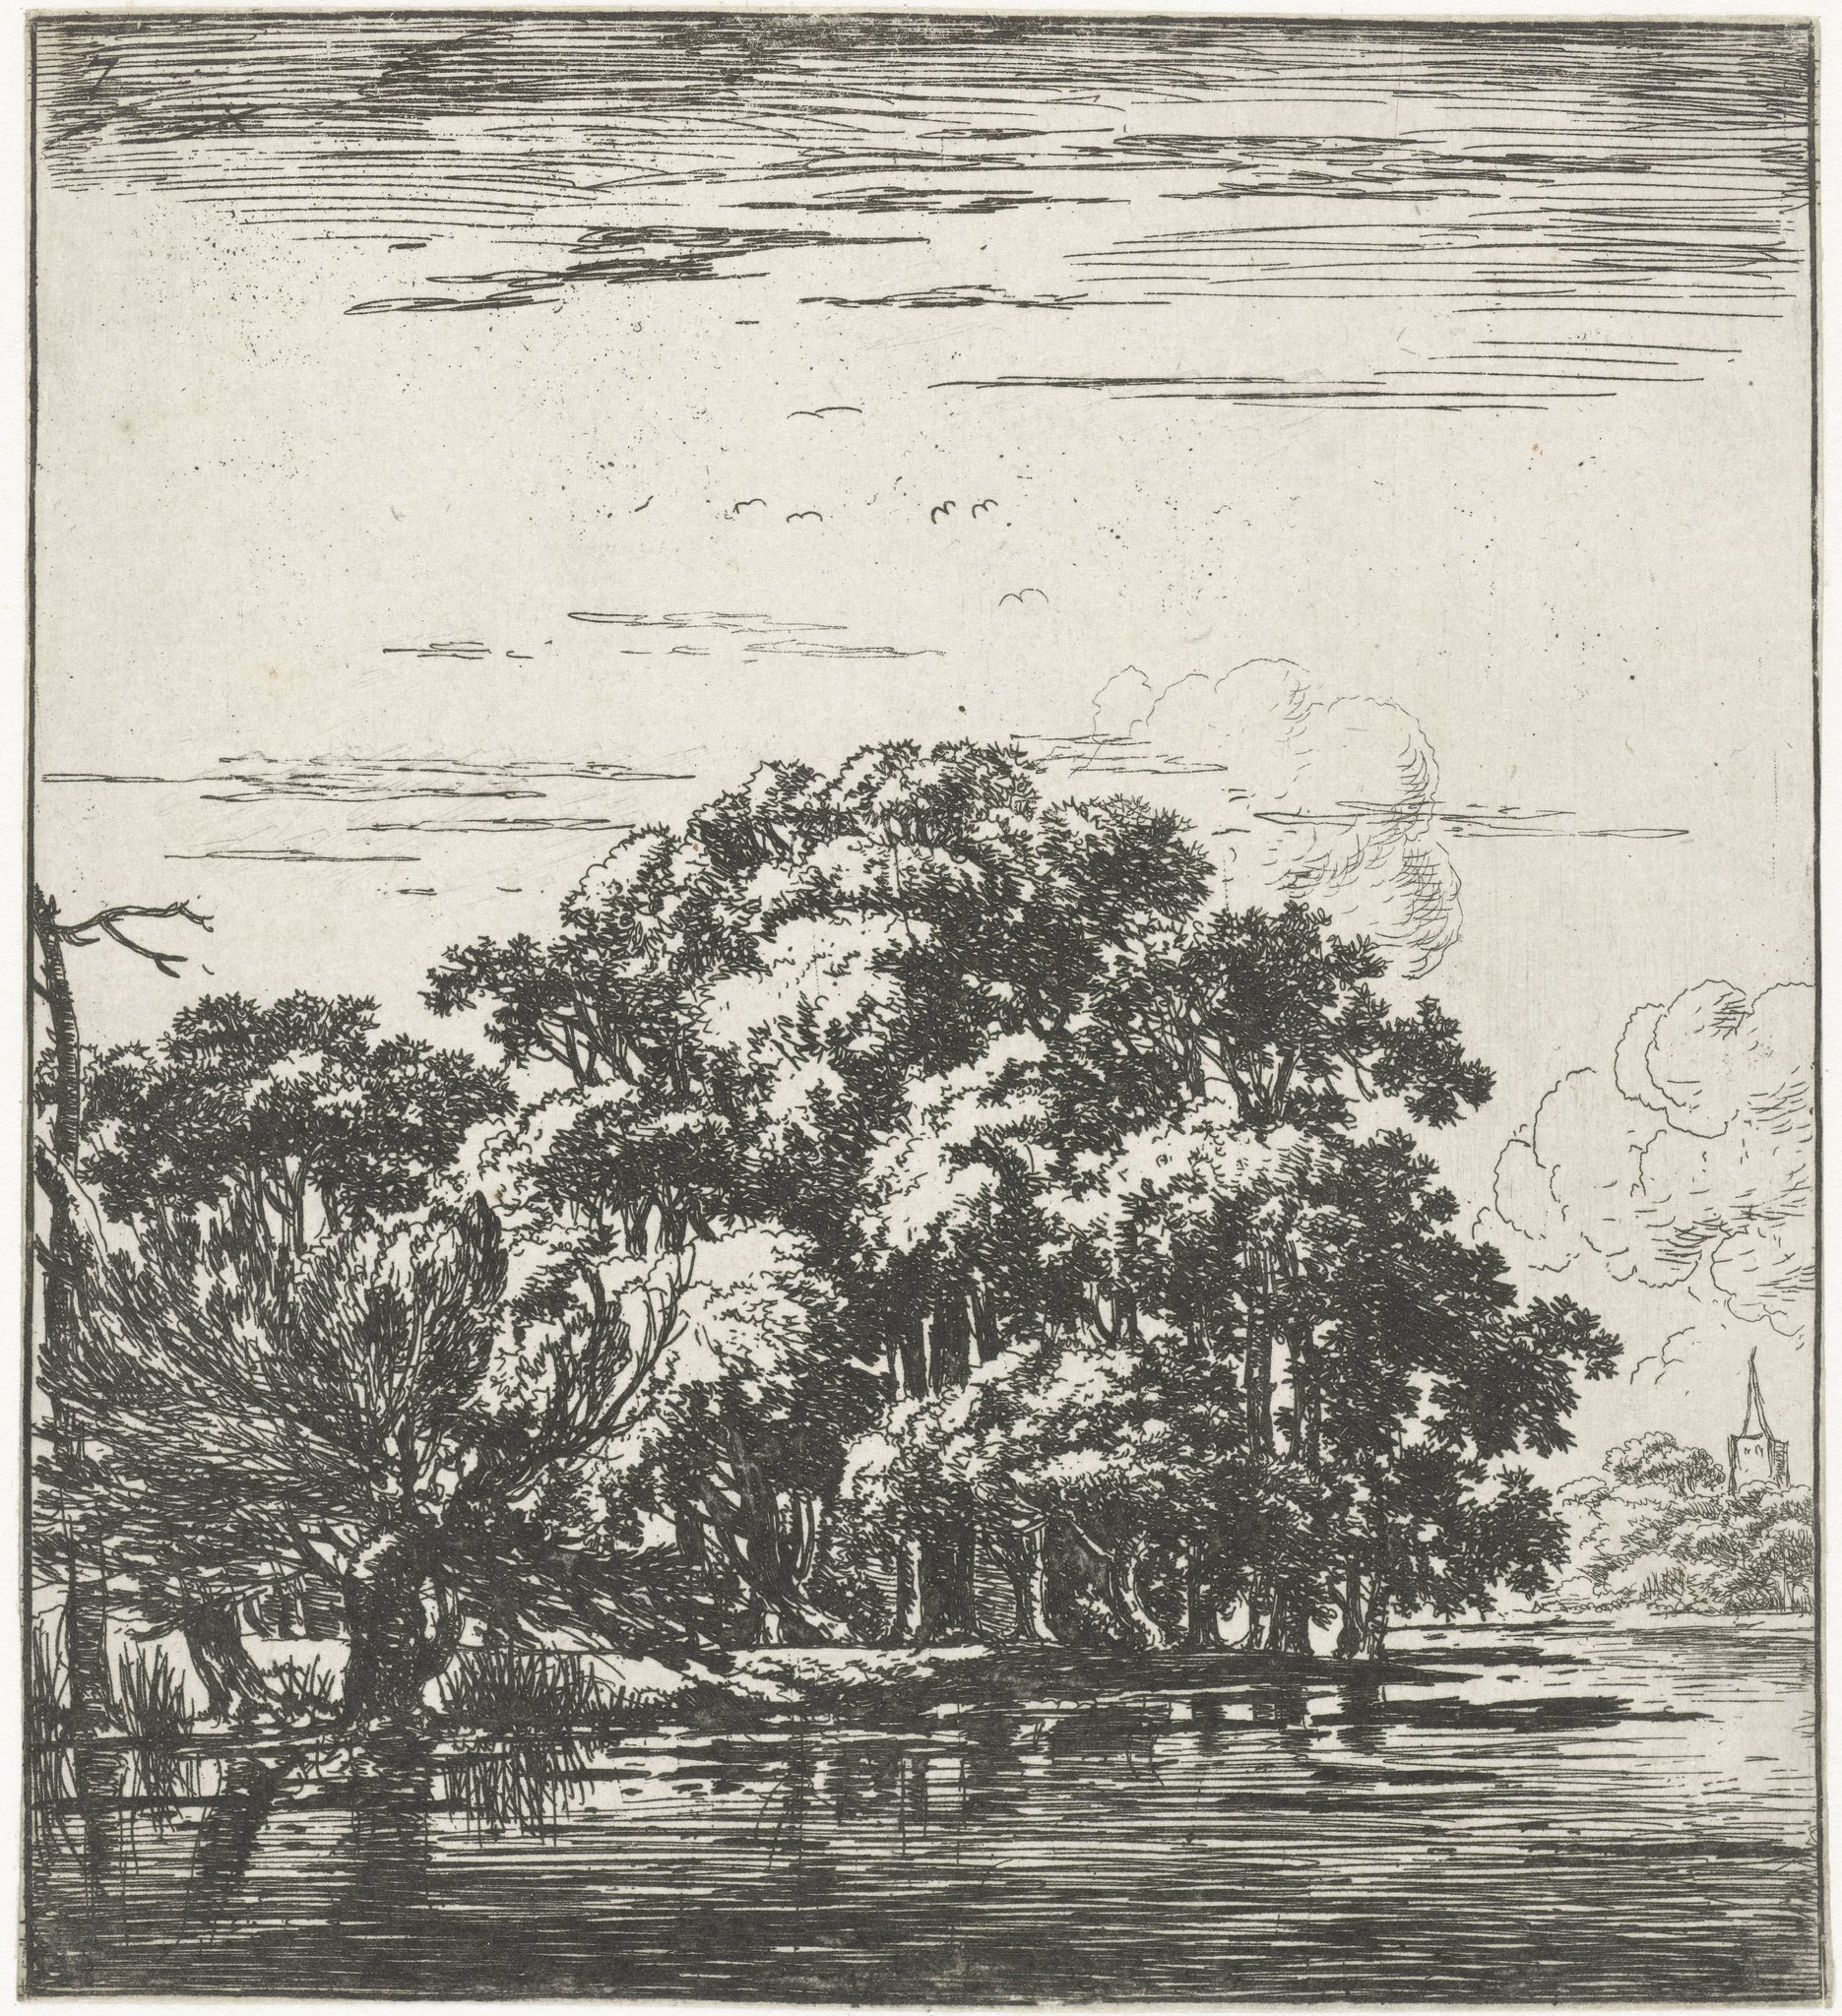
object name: print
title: Serie 2: Landschappen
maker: herman naiwincx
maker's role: draughtsman, print maker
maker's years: 1623-1670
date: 1633-1670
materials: paper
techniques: etching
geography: amsterdam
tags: river, church (exterior), forest, wood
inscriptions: collector's mark: Lugt 240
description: Een rivier met een beboste oever. Rechts tussen de bomen een kerktoren.